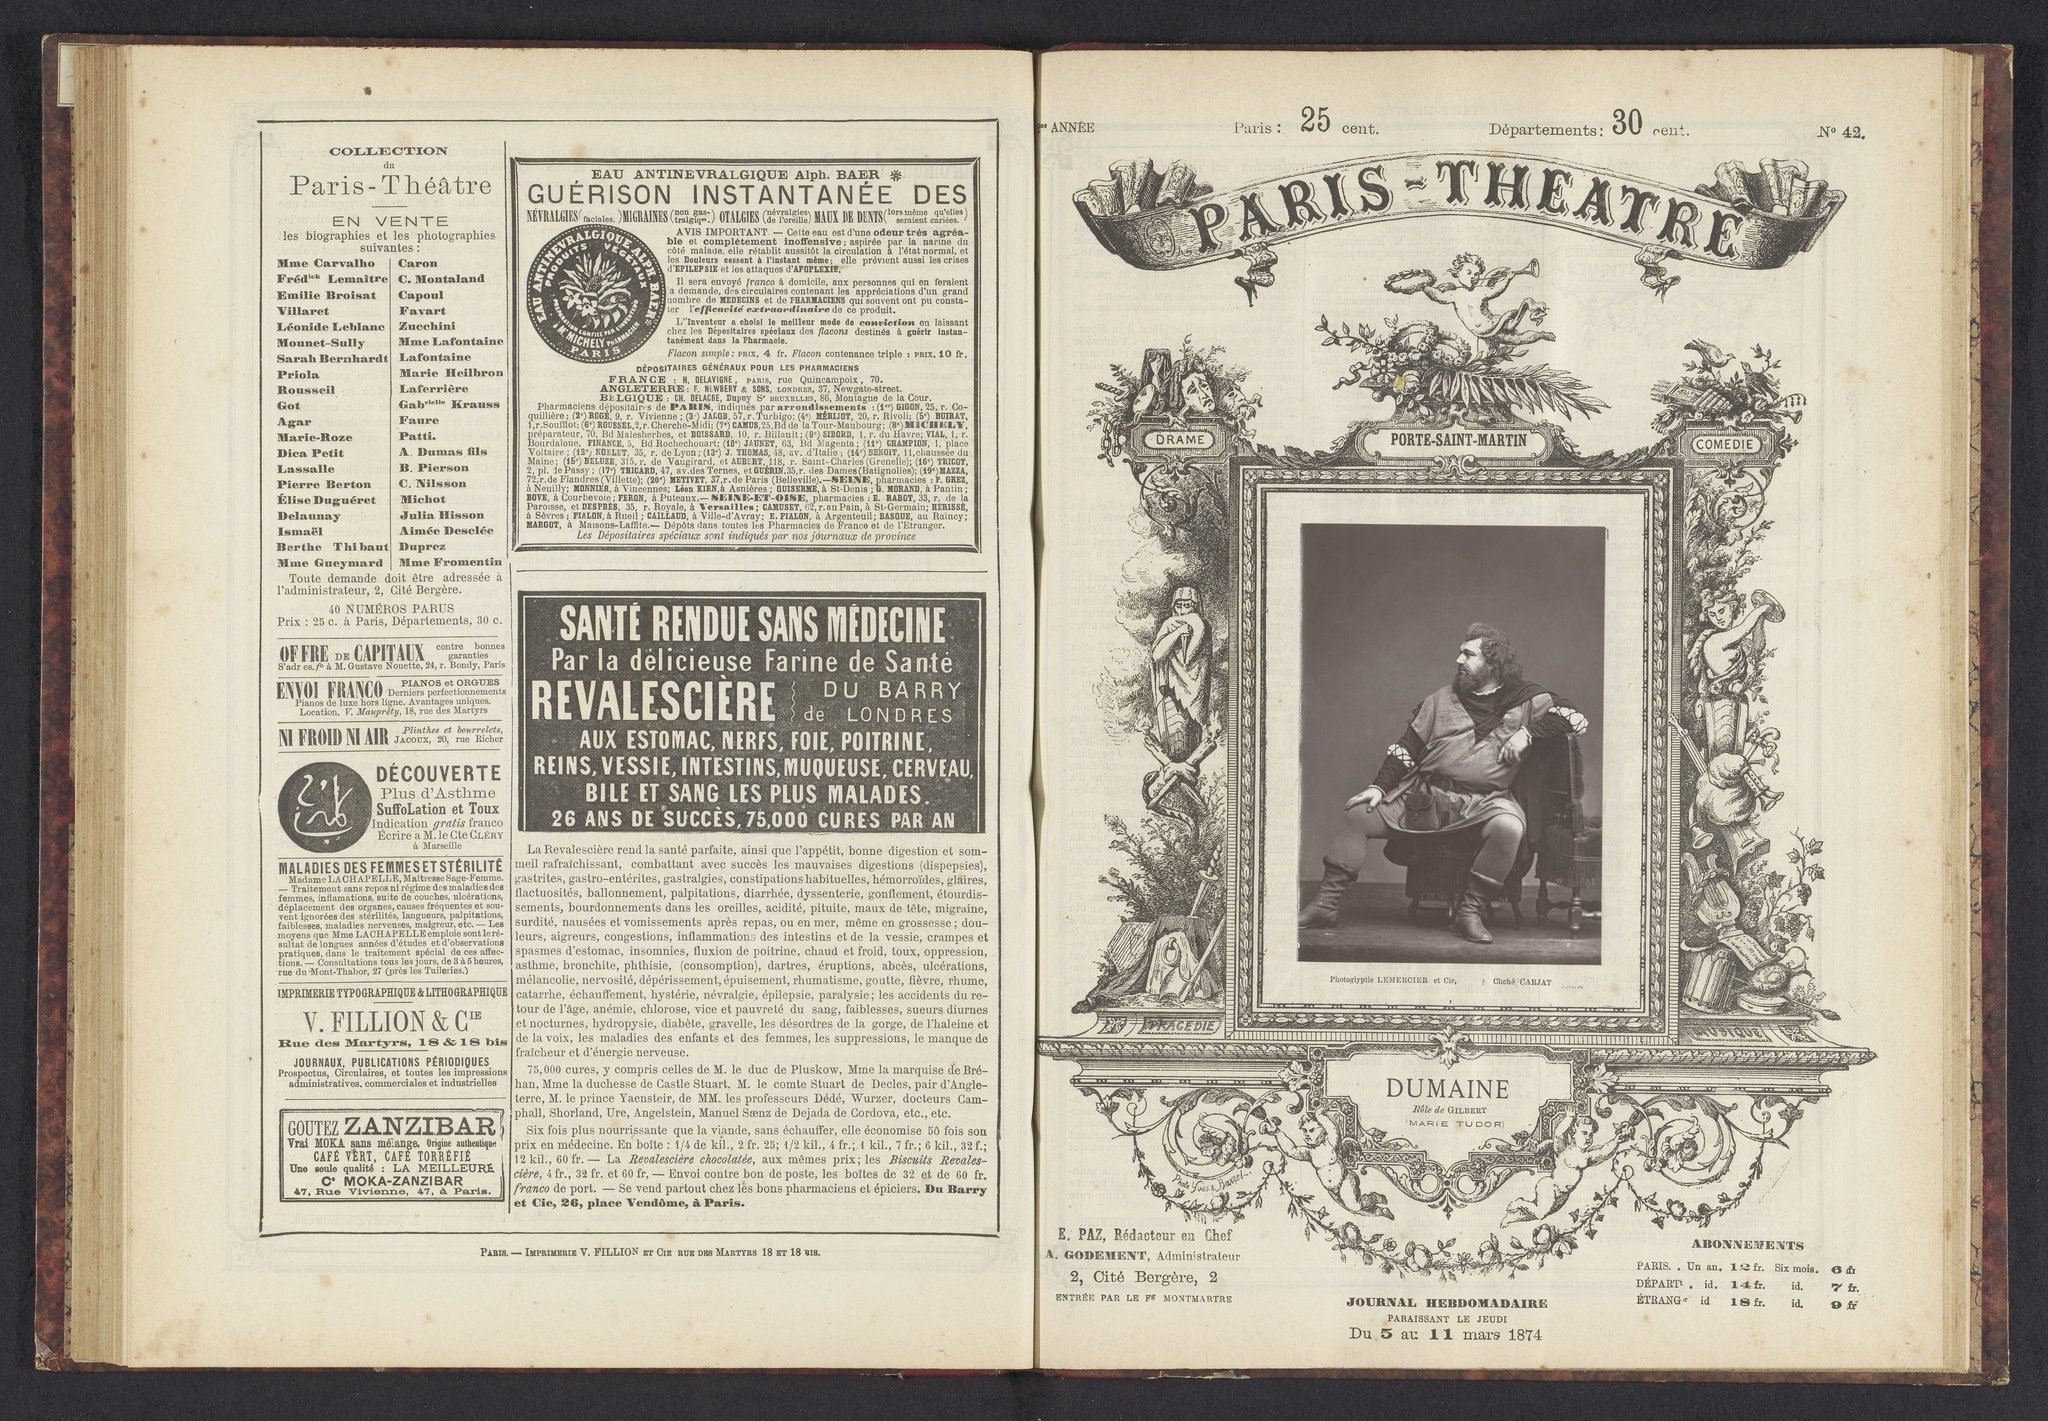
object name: page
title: Dumaine Rôle de Gilbert (Marie Tudor)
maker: étienne carjat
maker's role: draughtsman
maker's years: 1828-1906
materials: paper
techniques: woodburytype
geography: france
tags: paris, portrait of actor, actress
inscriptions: number: ‘No 42.’, inscription: ‘Journal hebdomadaire paraissant le Jeudi Du 5 au 11 mars 1874’